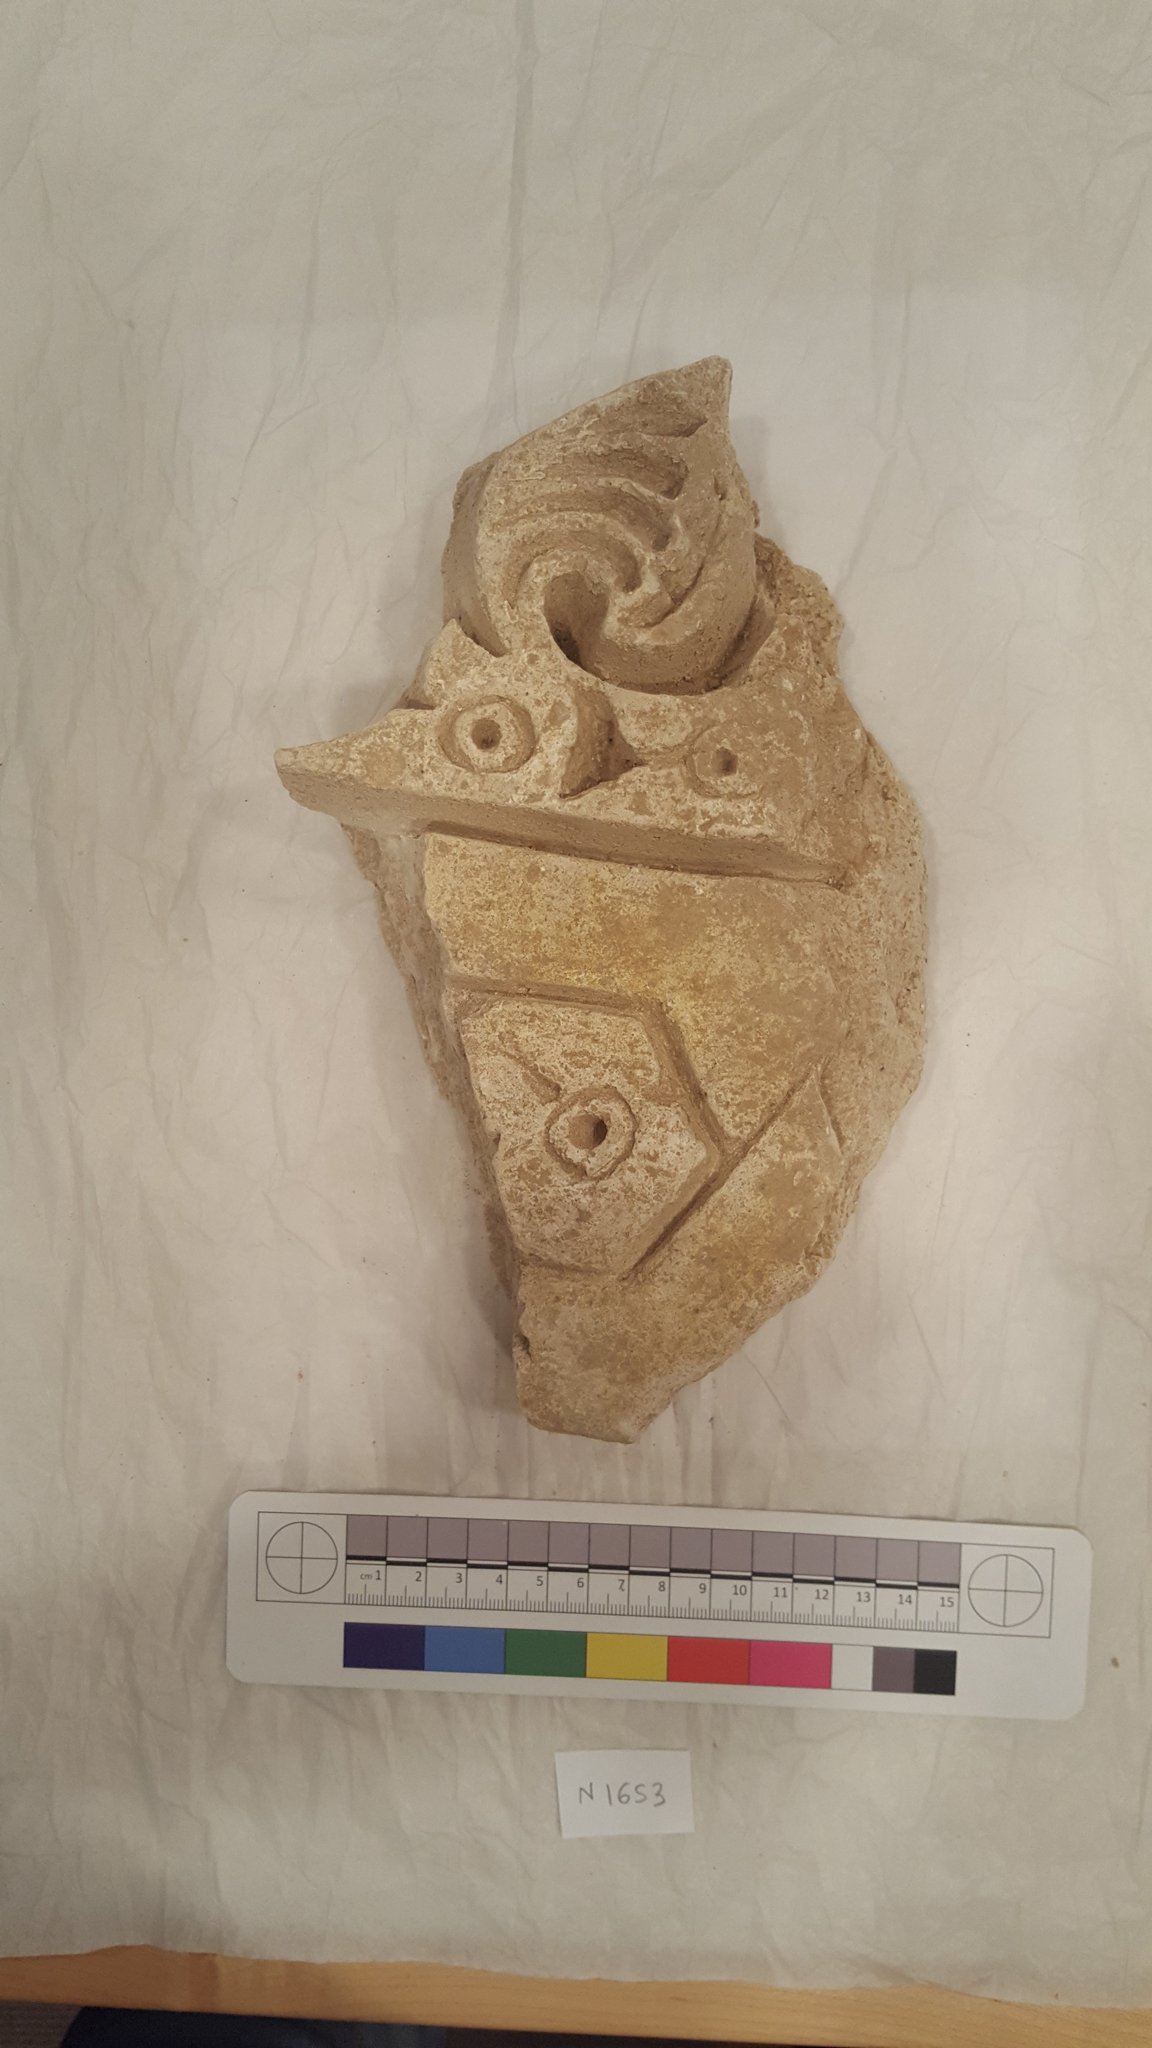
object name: fragment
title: Stucco Fragment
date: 701-1200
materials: plaster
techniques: carving, painting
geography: iran